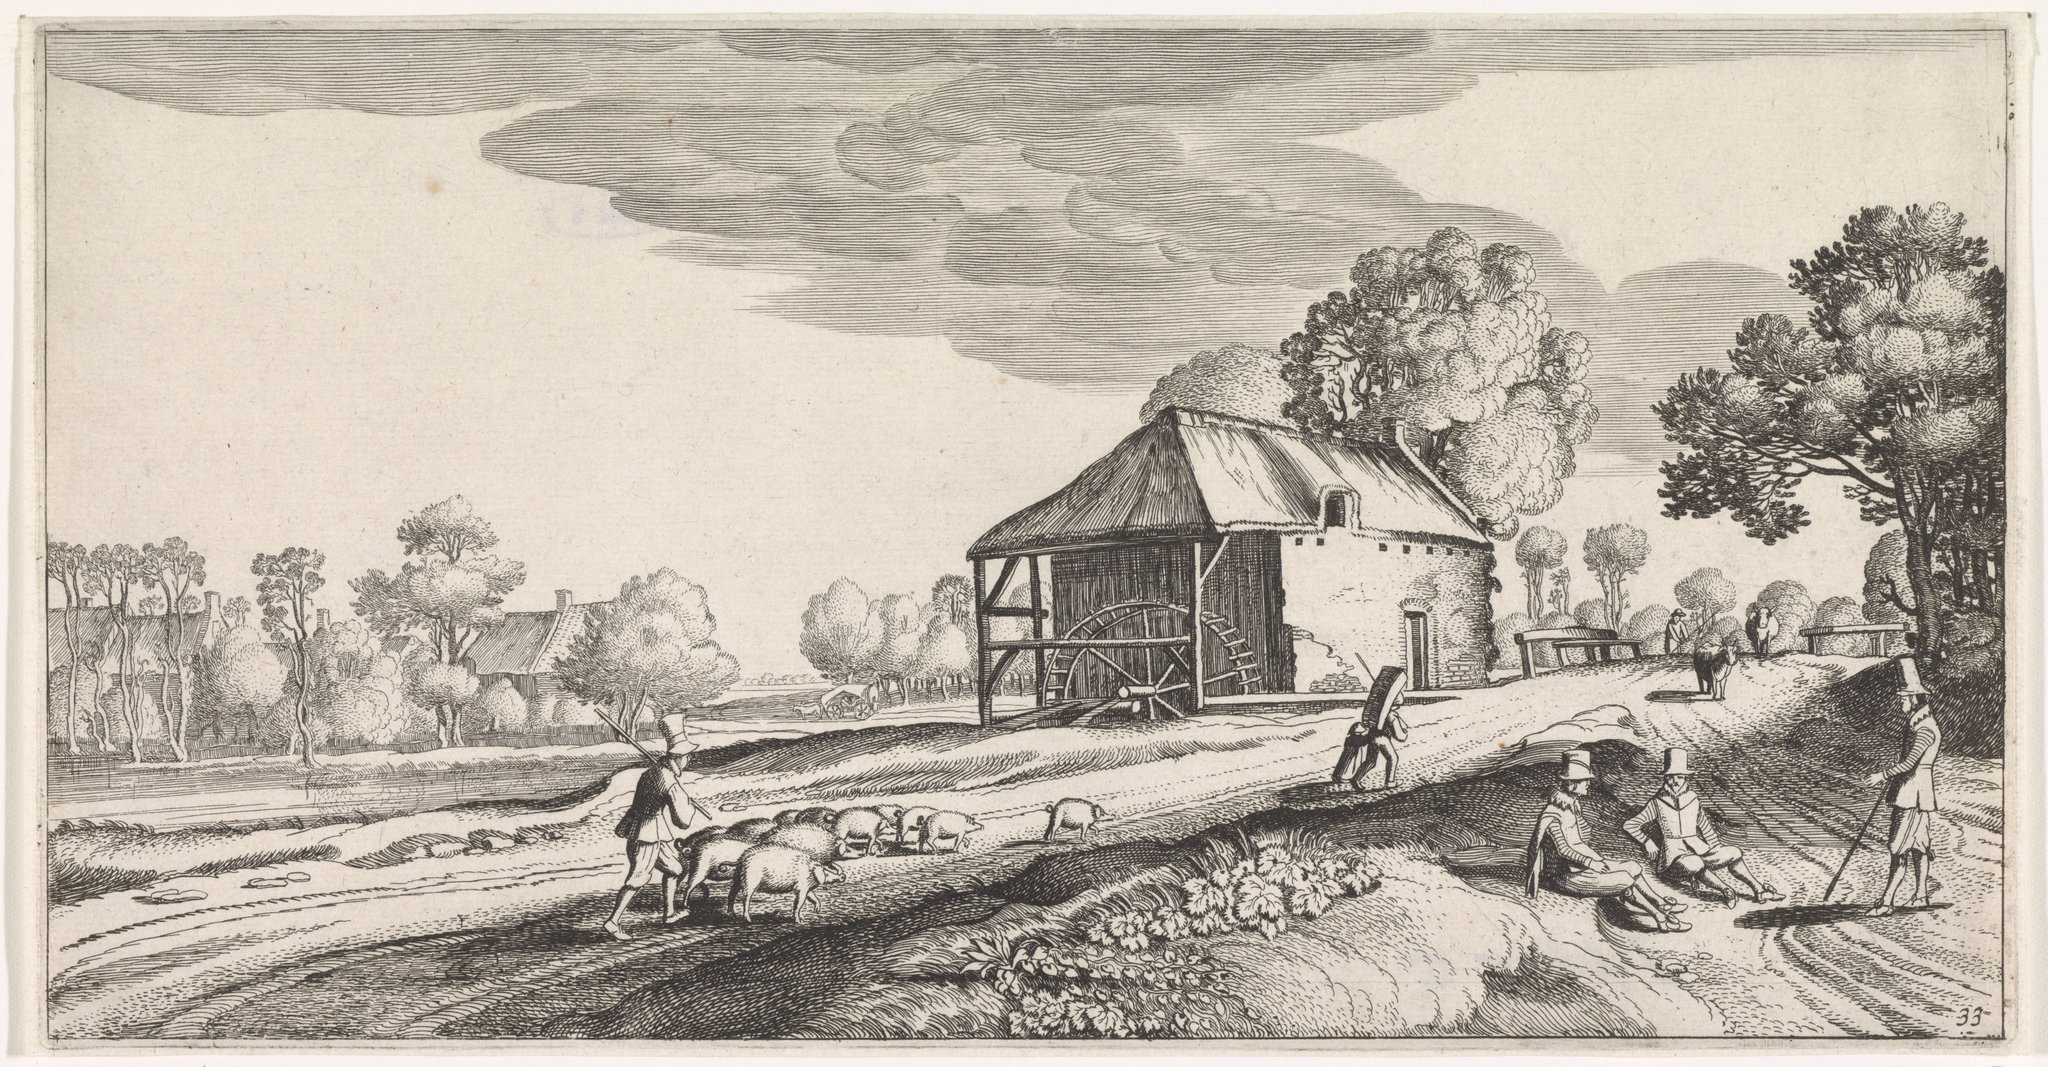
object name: print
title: Wegsplitsing bij een watermolen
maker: jan van de velde (ii)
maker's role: draughtsman, painter, print maker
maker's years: 1593-1641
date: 1639-1641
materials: paper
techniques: etching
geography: northern netherlands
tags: pig, herding, herdsman, herdswoman, shepherd, shepherdess, cowherd, etc., cross-roads, bifurcation, watermill in landscape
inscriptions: collector's mark: Lugt 240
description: Wegsplitsing voor een watermolen aan een rivier. Links een herder met een kudde varkens en een man met een kind; rechts een groepje pratende heren. 33ste prent van een serie met 36 prenten van landschappen, verdeeld over zes delen.